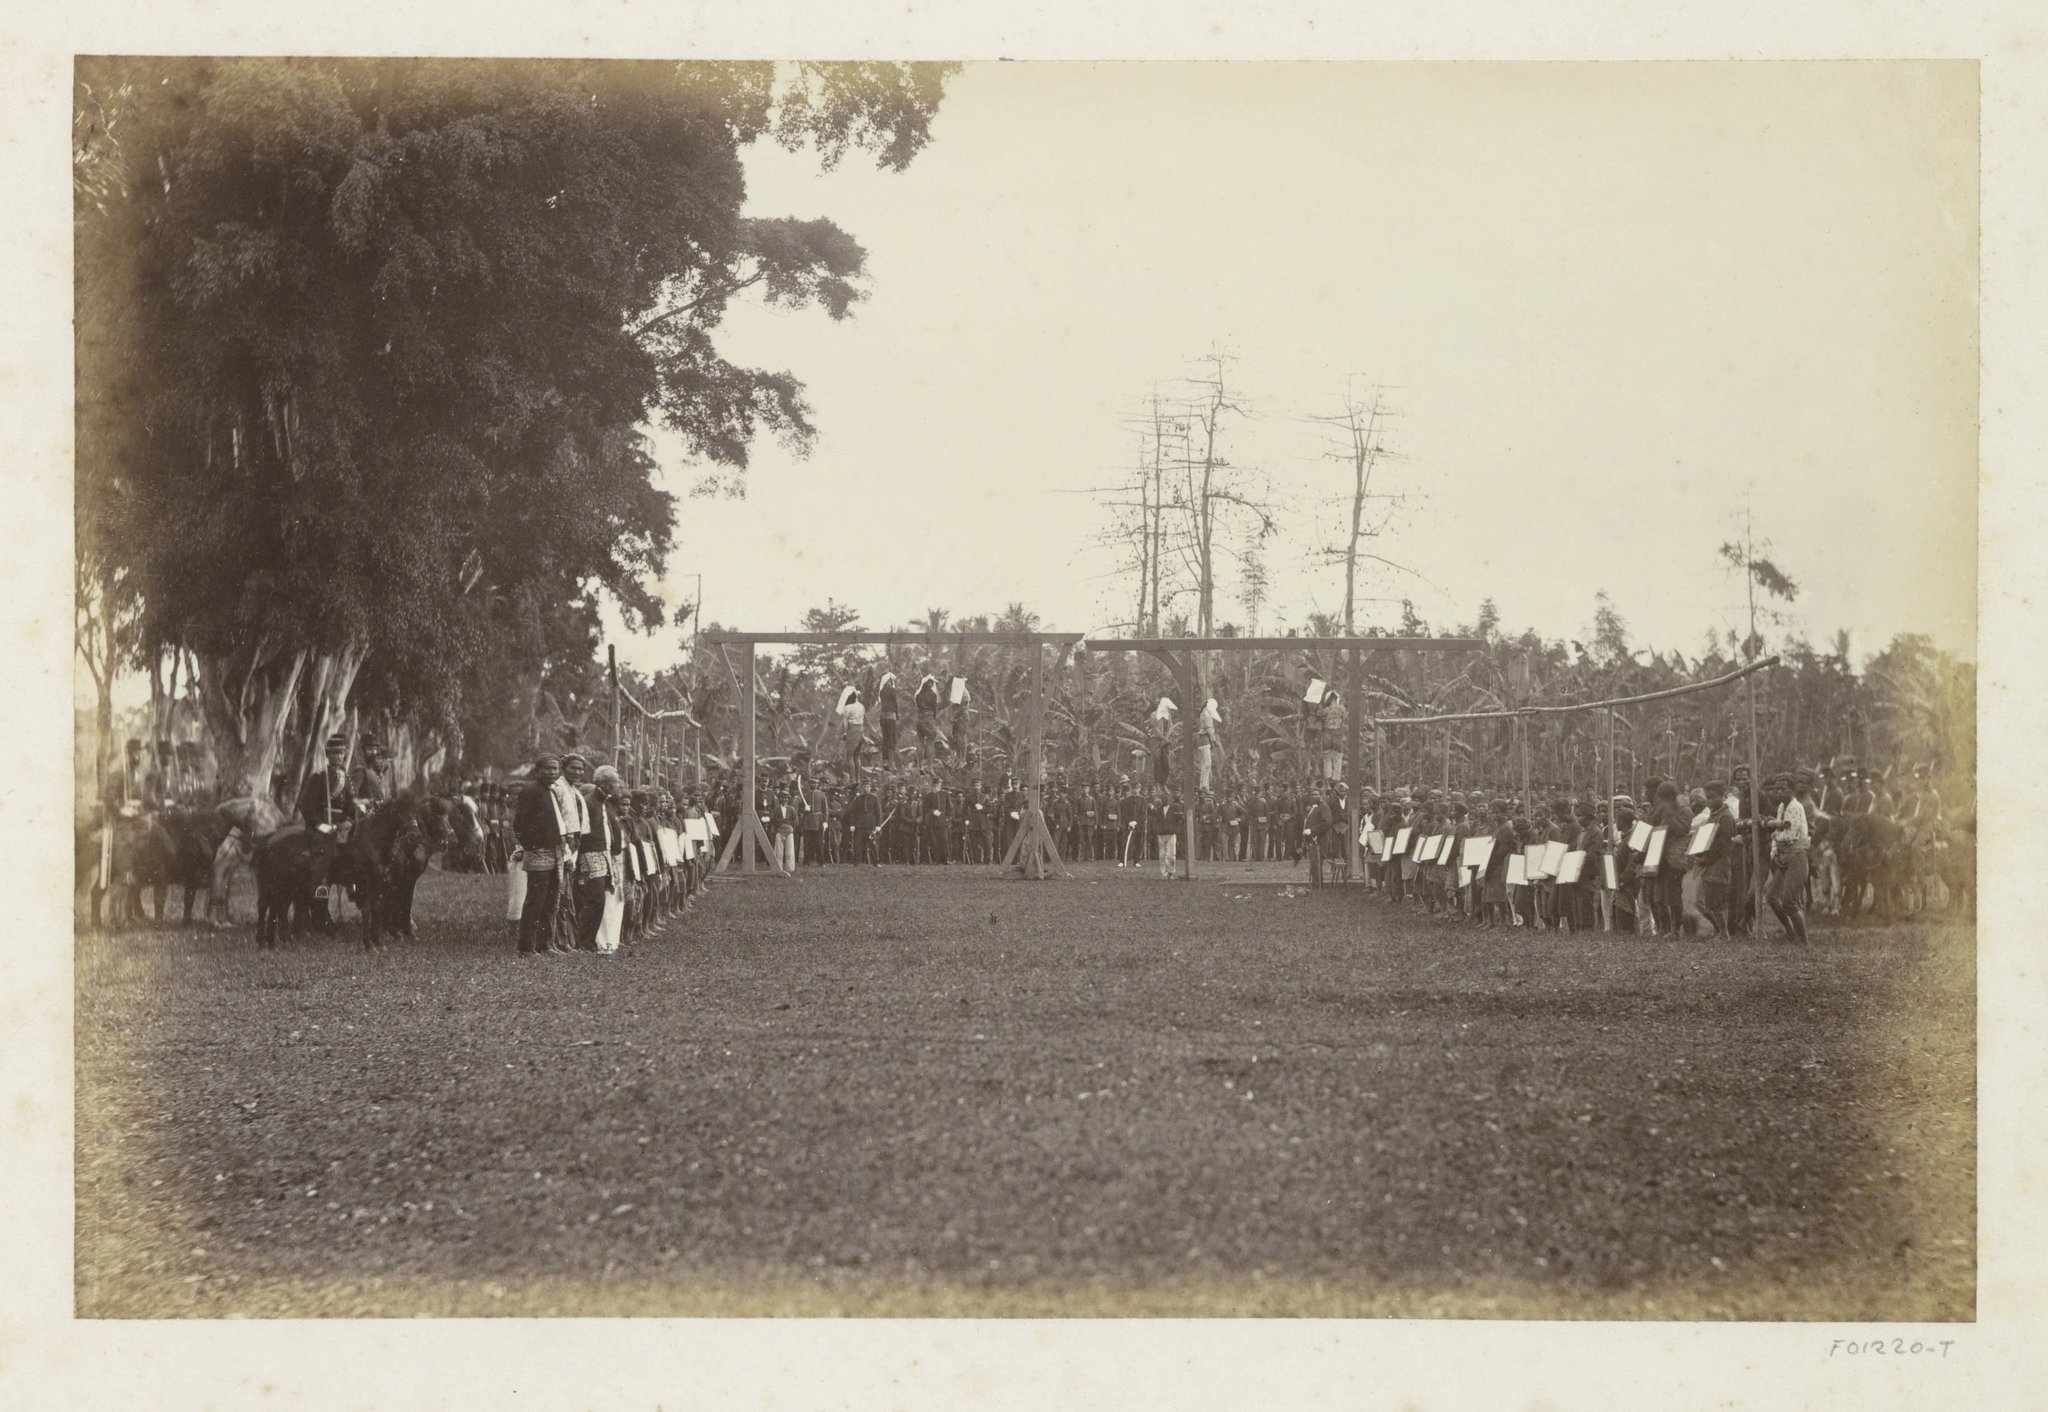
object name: photograph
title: Executie van acht zogenaamde Tamboenmoordenaars in Bekasi op Java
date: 1870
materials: photographic support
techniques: albumen print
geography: bekasi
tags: instruments of torture, execution or punishment: gallows, death penalty, execution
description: Onderdeel van Fotoalbum met opnames van bezienswaardigheden op Java.